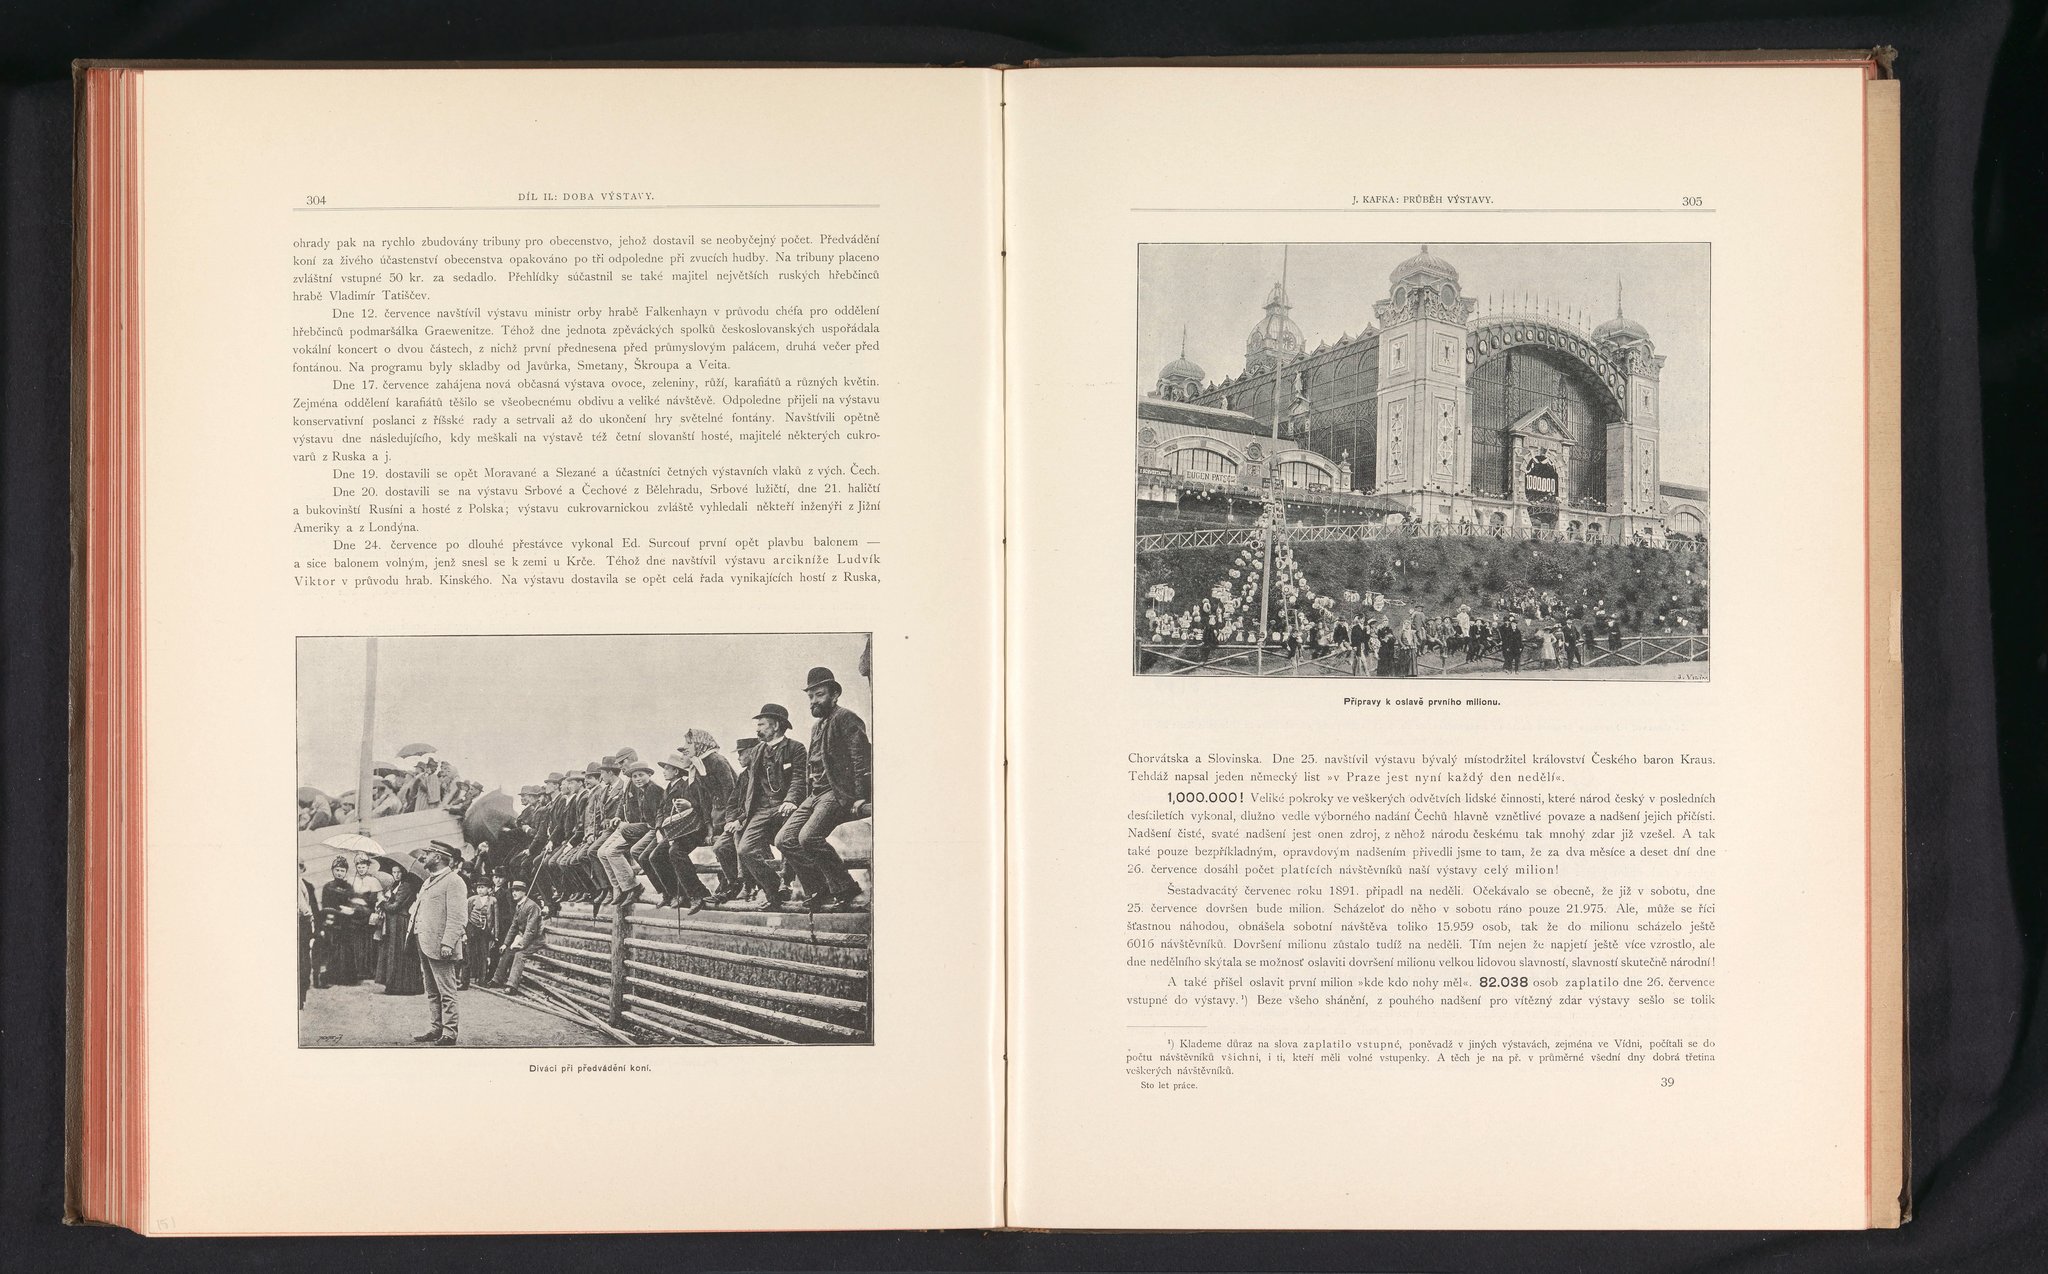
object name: page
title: Pripravy k oslave prvniho milionu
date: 1891-1893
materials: paper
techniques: autotype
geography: prague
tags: façade (of house or building), temporary exhibition, 'salon'